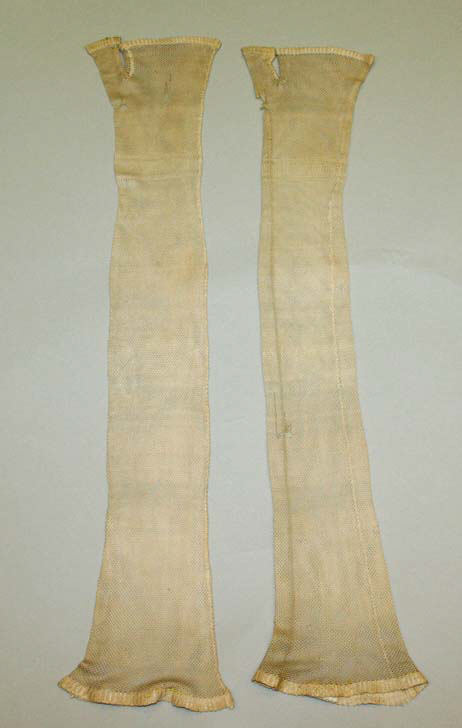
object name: mitt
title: Mitts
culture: italian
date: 1850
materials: silk